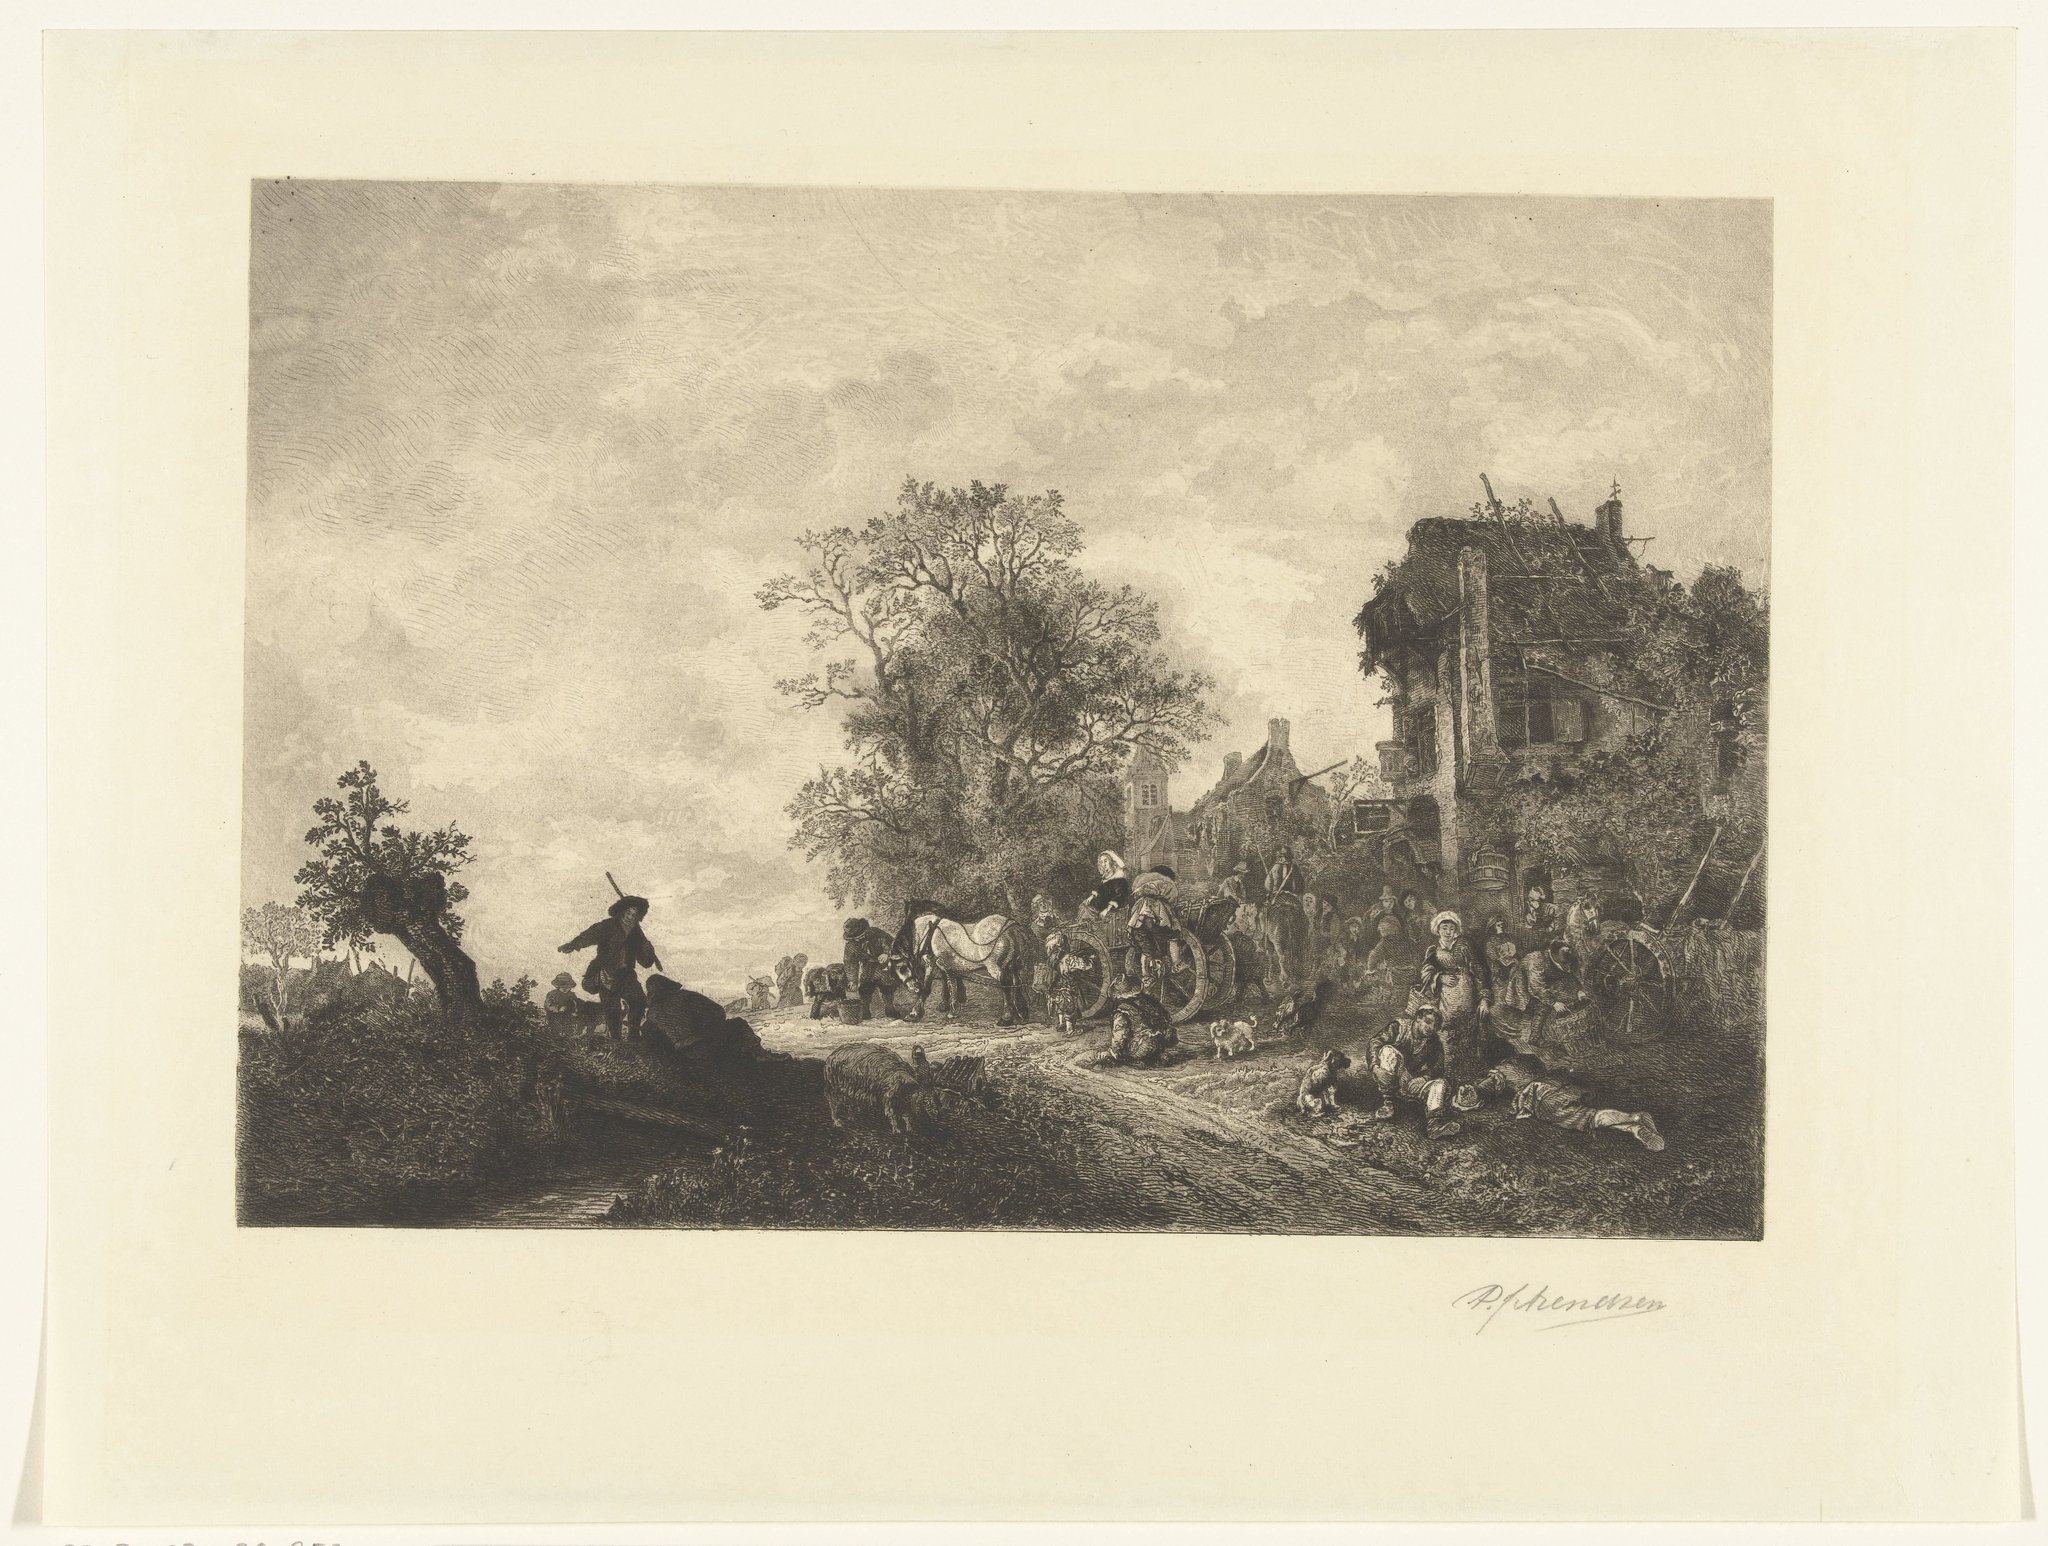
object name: print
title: Boeren voor een herberg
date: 1856-1900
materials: paper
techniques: aquatint, etching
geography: netherlands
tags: farmers, road, path, hotel, hostelry, inn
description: Een twintigtal boeren op en langs de weg voor een herberg.